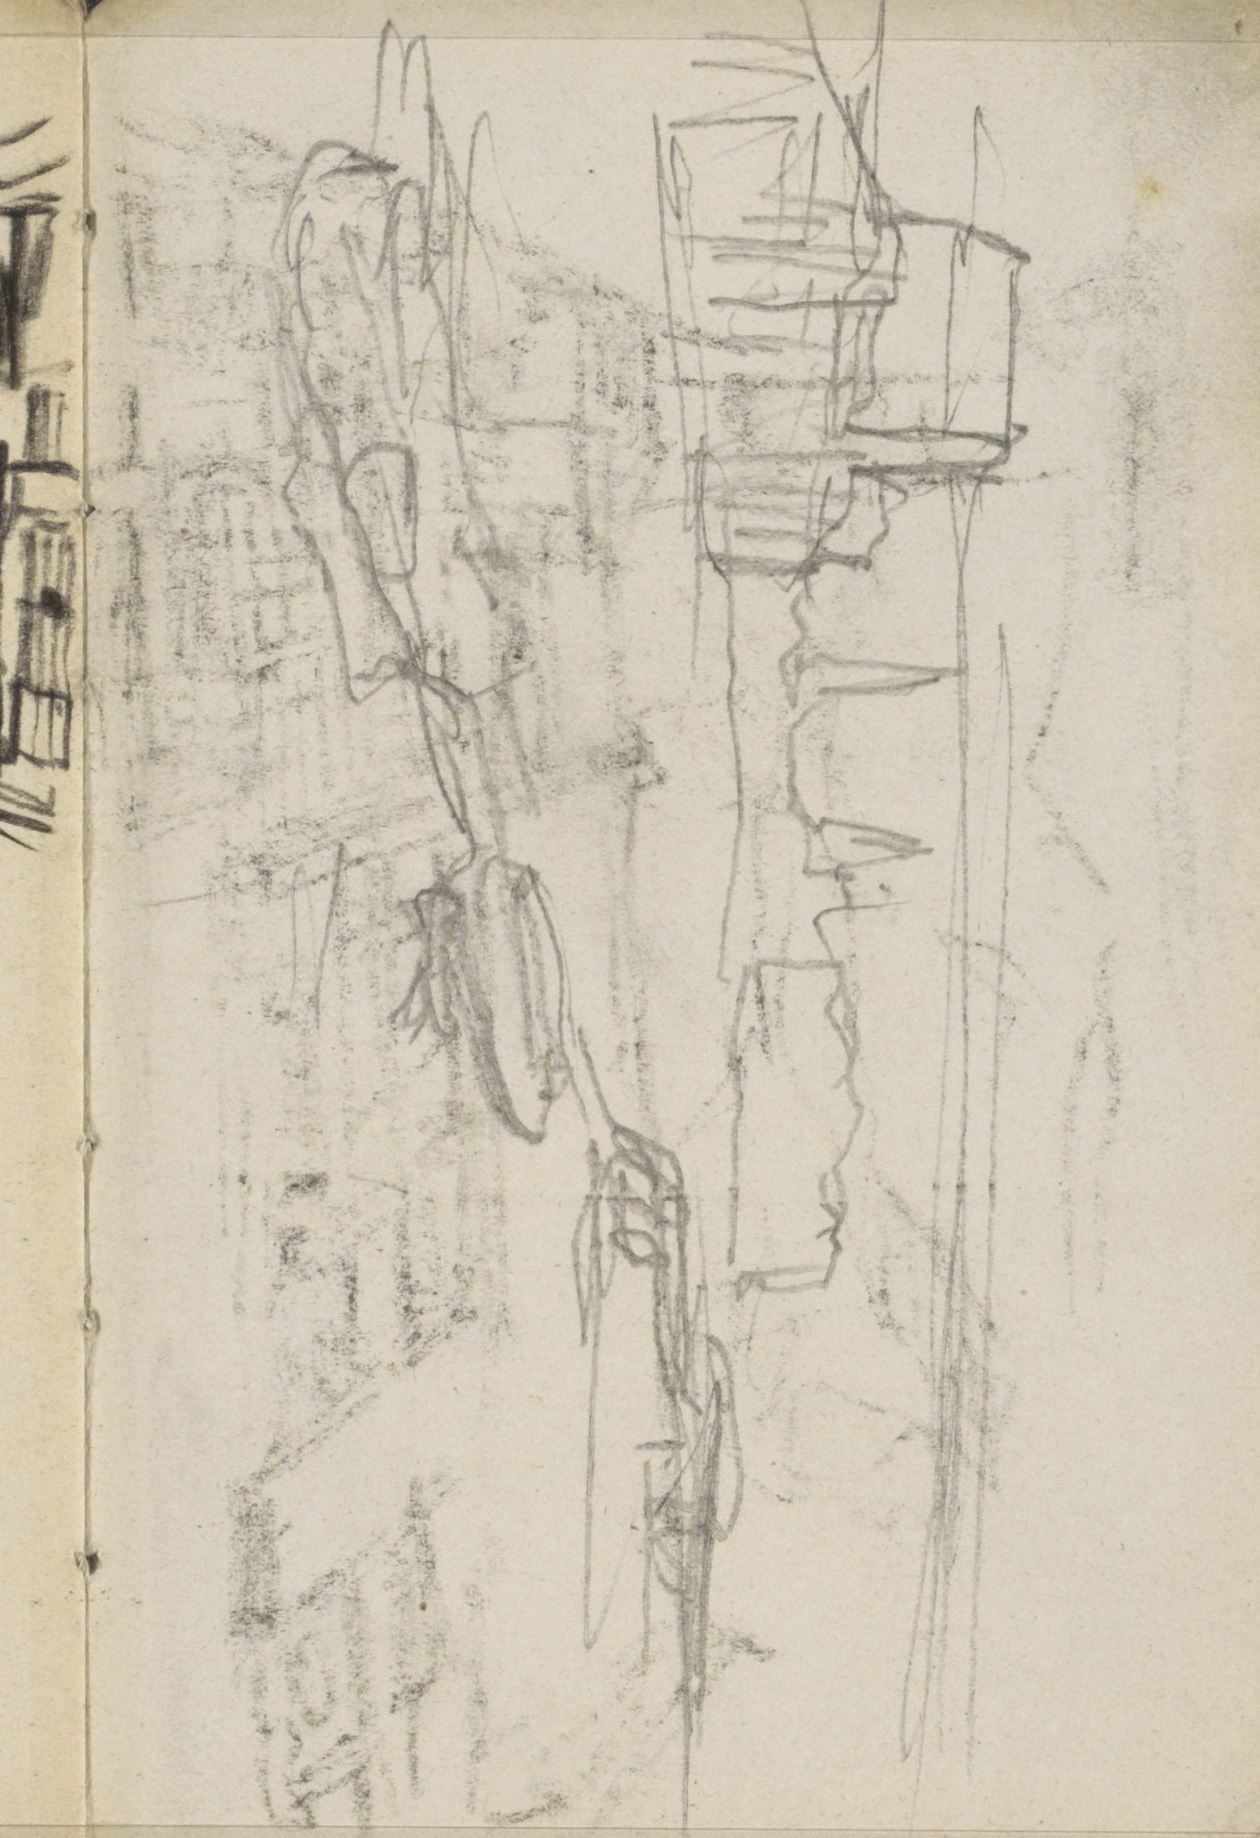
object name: sketchbook leaf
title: Gezicht op schepen aan de Prins Hendrikkade te Amsterdam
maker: george hendrik breitner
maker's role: draughtsman, painter, print maker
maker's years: 1857-1923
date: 1903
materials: paper, pencil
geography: amsterdam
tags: ships (in general), quay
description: Gezicht op schepen aan de Prins Hendrikkade te Amsterdam. Pagina 92 uit een schetsboek met 46 bladen vervaardigd te Amsterdam en Haarlem.